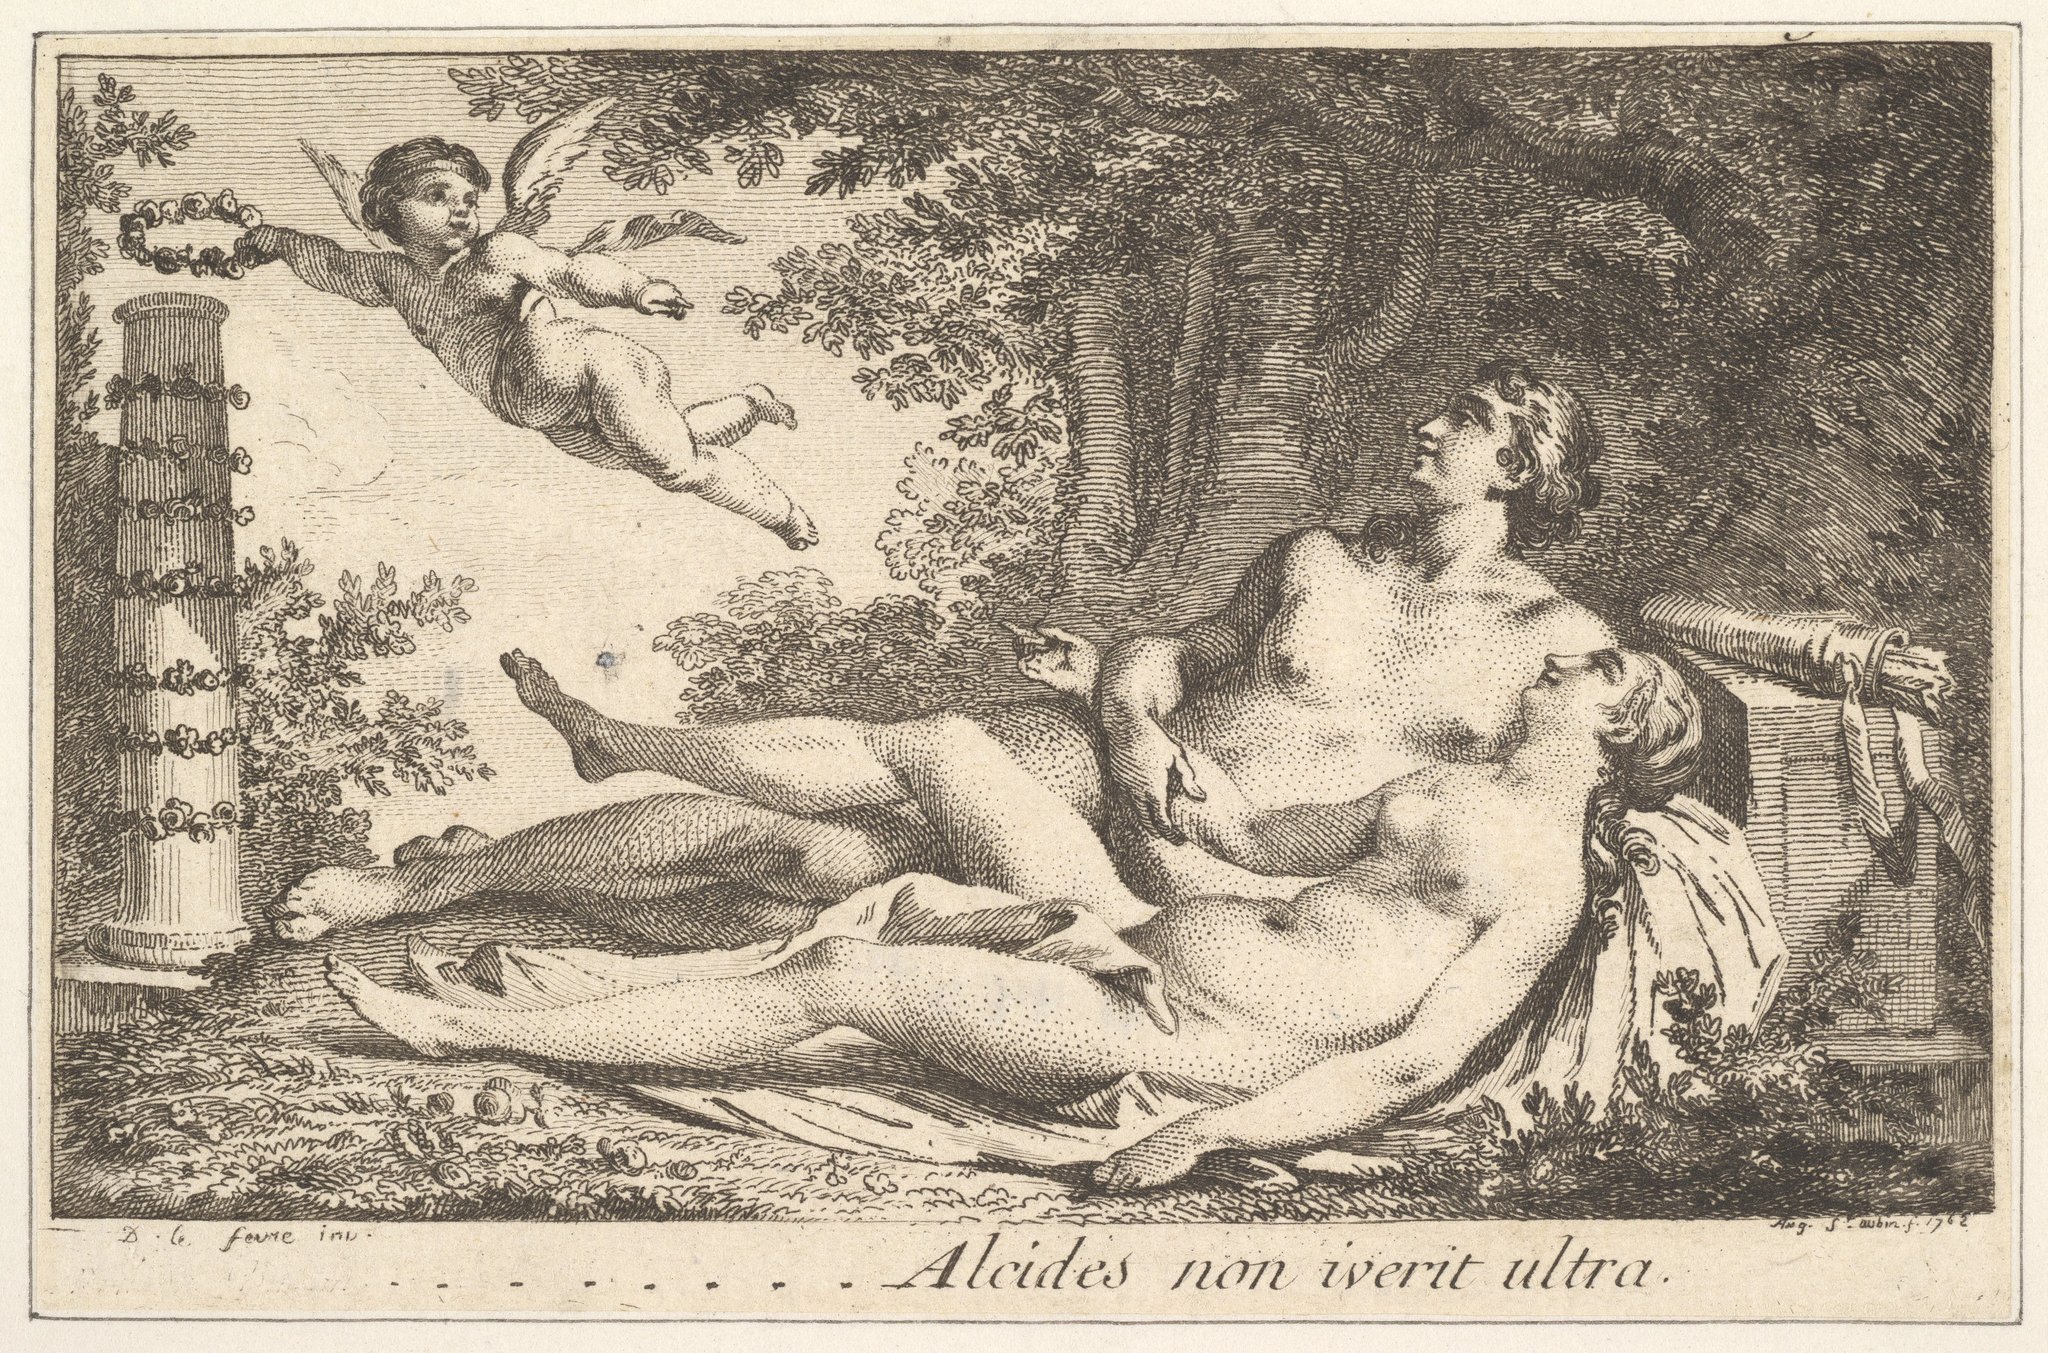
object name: print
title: Vignette en regard du nom de Aug. de St. Aubin (Vignette next to the name of Augustin de Saint-Aubin), volume 2, plate 150 of "Dictionnaire des Graveurs. Anciens et Modernes Depuis l'origine de la Gravure, par F. Basan Graveur, Seconde Edition [...] 1789"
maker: augustin de saint-aubin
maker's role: artist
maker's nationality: french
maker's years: 1736-1807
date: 1762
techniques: engraving, etching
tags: female nudes,putti